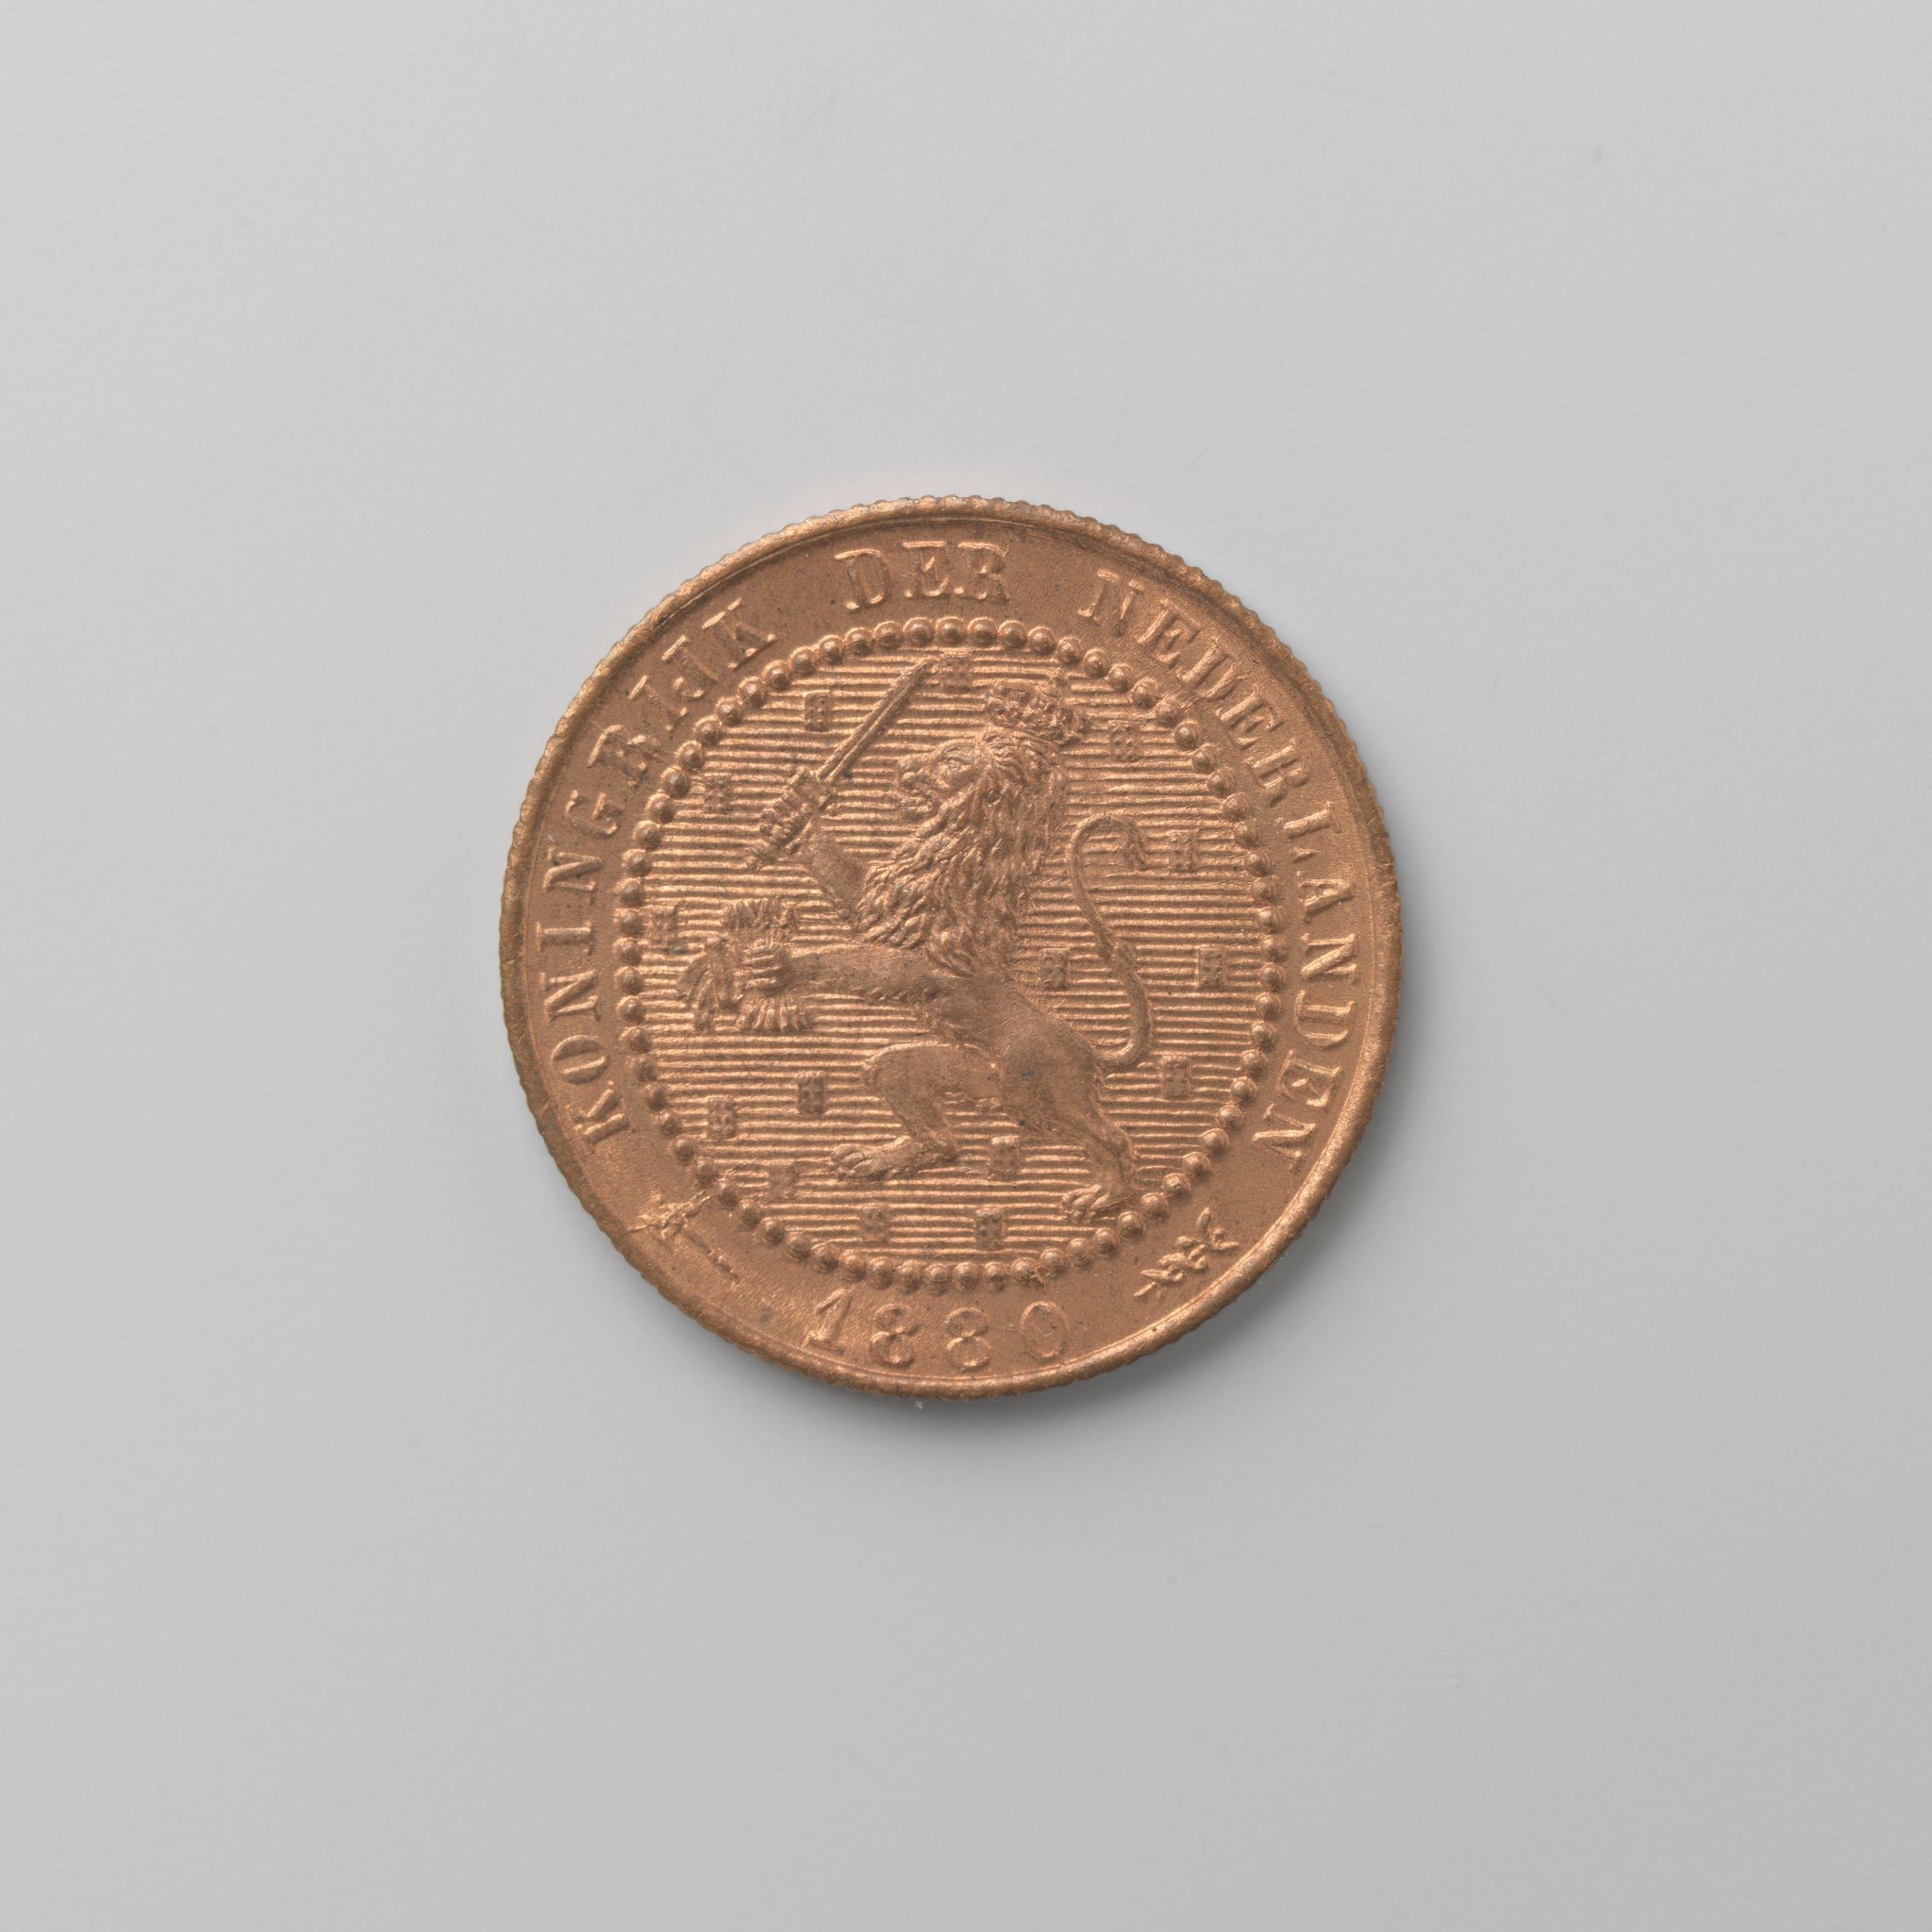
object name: coin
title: Nederlandse cent, 1880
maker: willem iii (koning der nederlanden)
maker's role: koning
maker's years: 1817-1890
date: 1880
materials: bronze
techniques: striking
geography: utrecht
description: Bronzen munt. Voorzijde: in een veld rijkswapen. Jaartal onderaan in omschrift. Keerzijde: binnen twee samengebonden oranjetakken waarde-aanduiding 1 cent. Kartelrand.